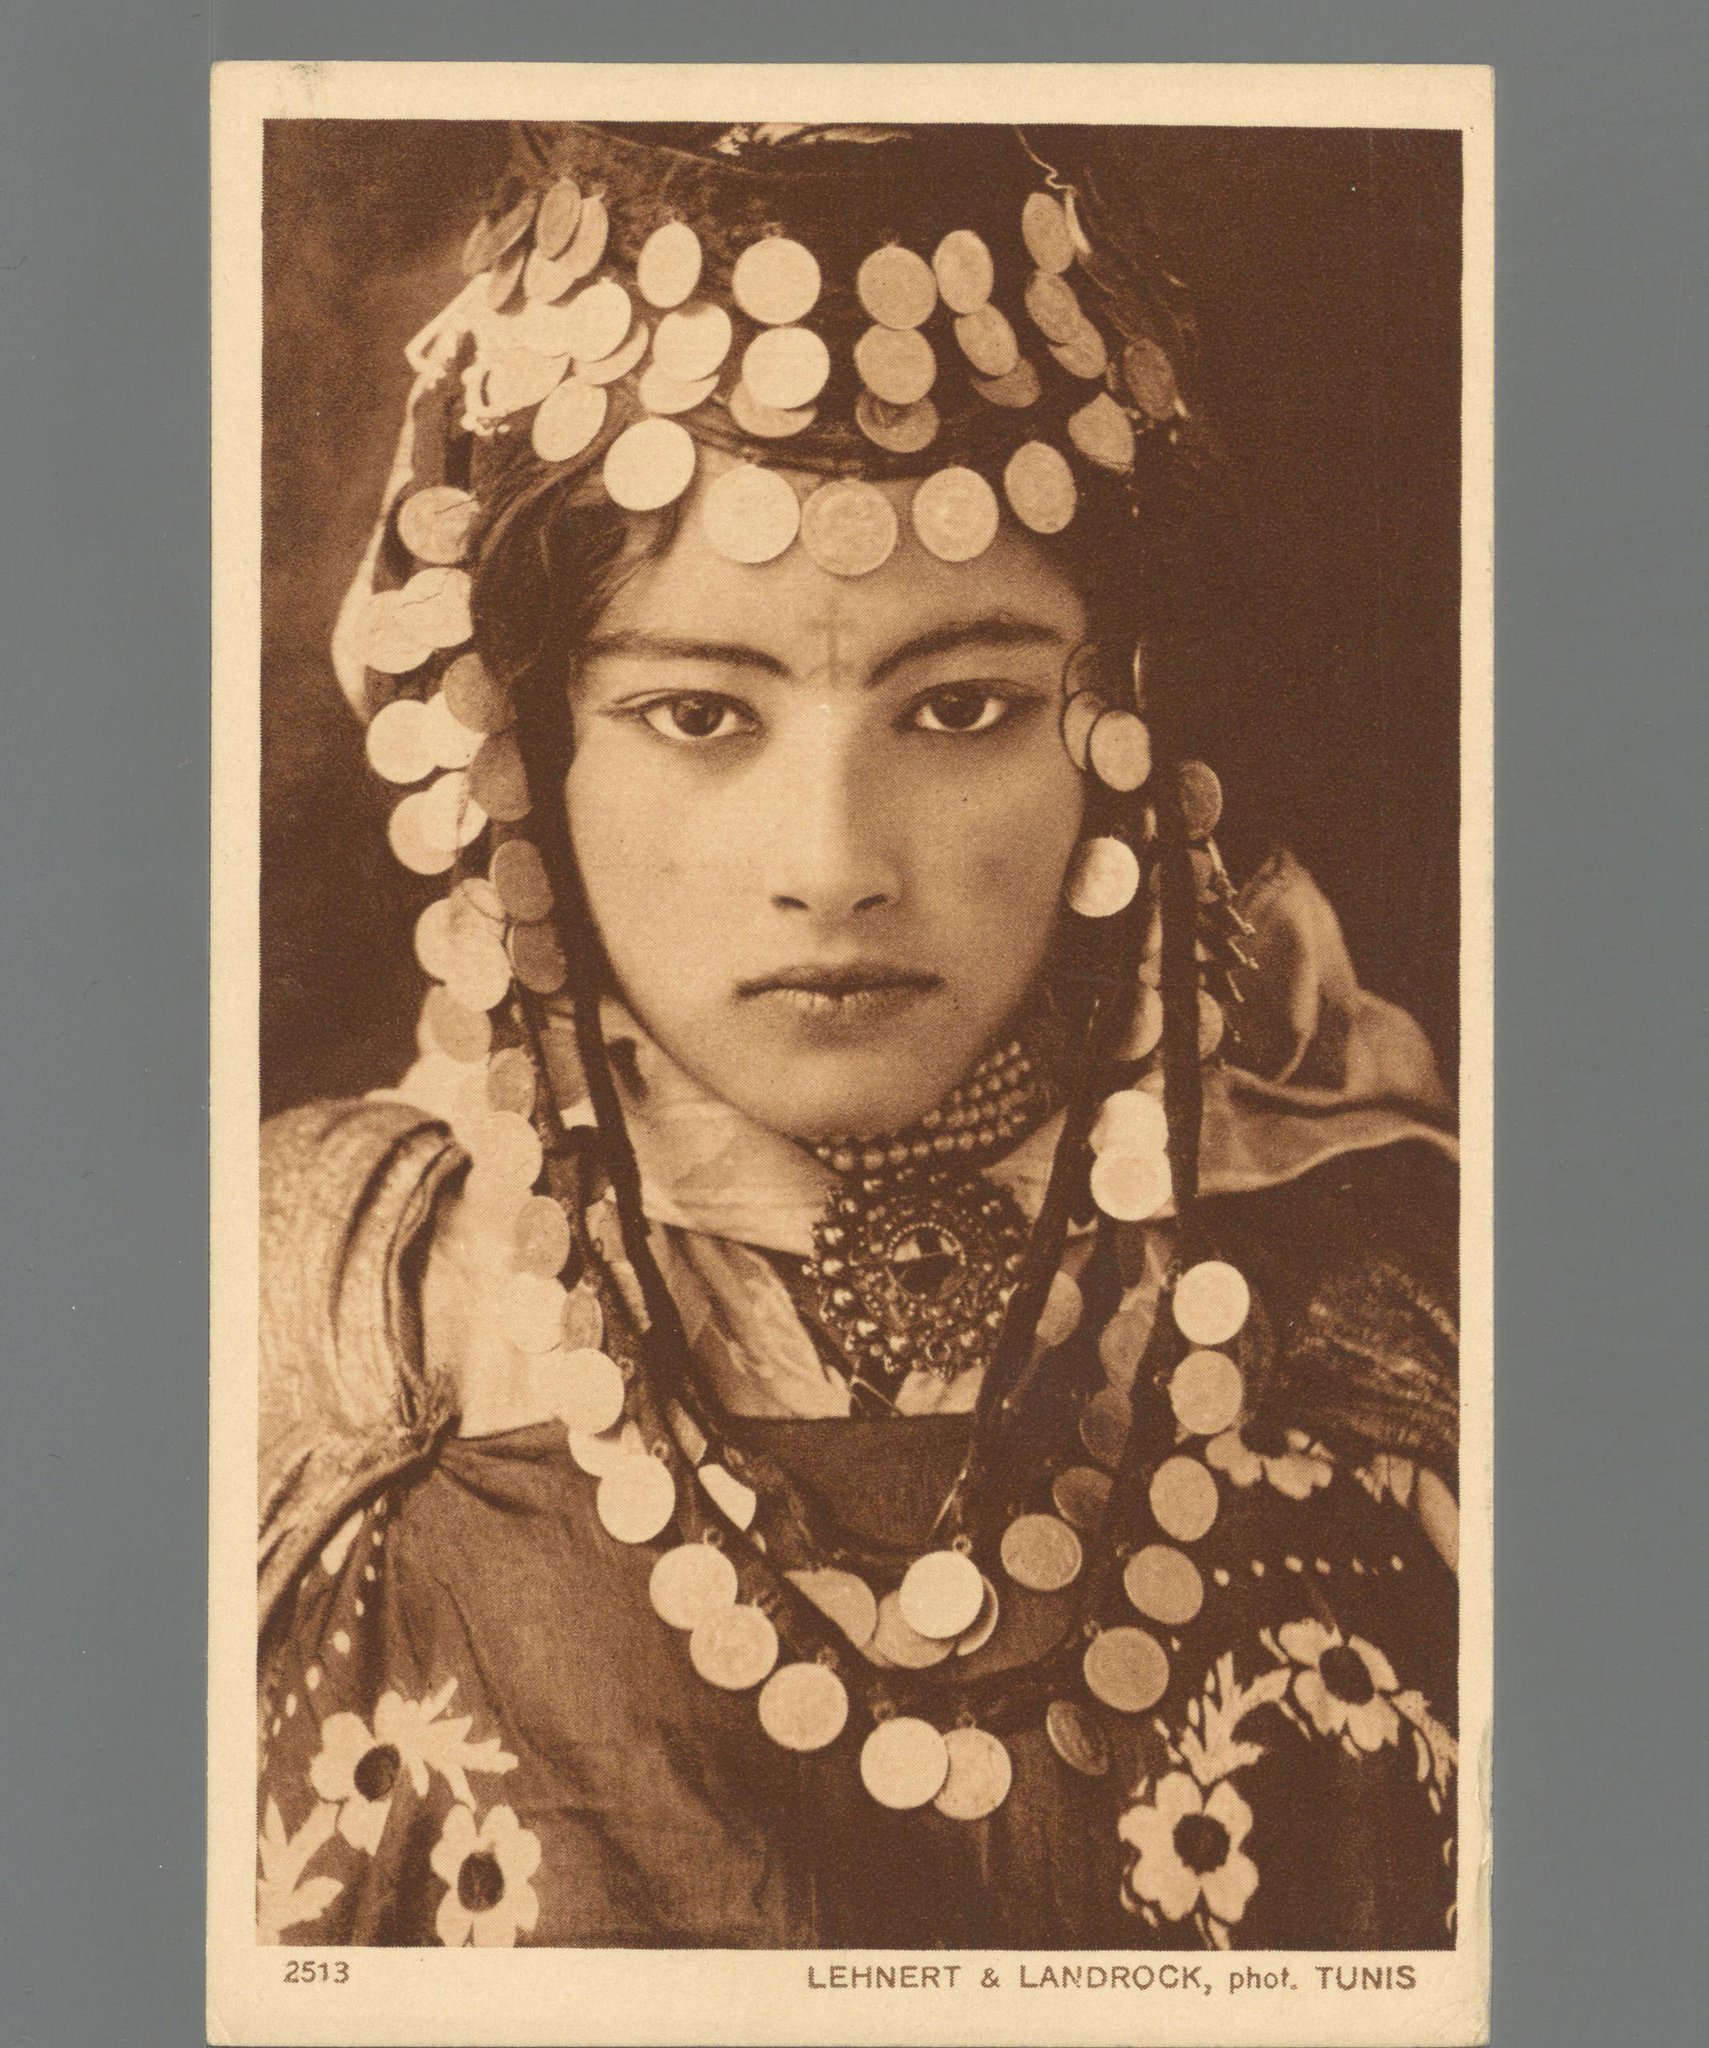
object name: ansichtkaart, prentbriefkaart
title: Types d'orient. Serie II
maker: Anonymous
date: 1903-1930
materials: cardboard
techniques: rotogravure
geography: tunisia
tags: head-gear, historical persons (portraits and scenes from the life) - bb - woman